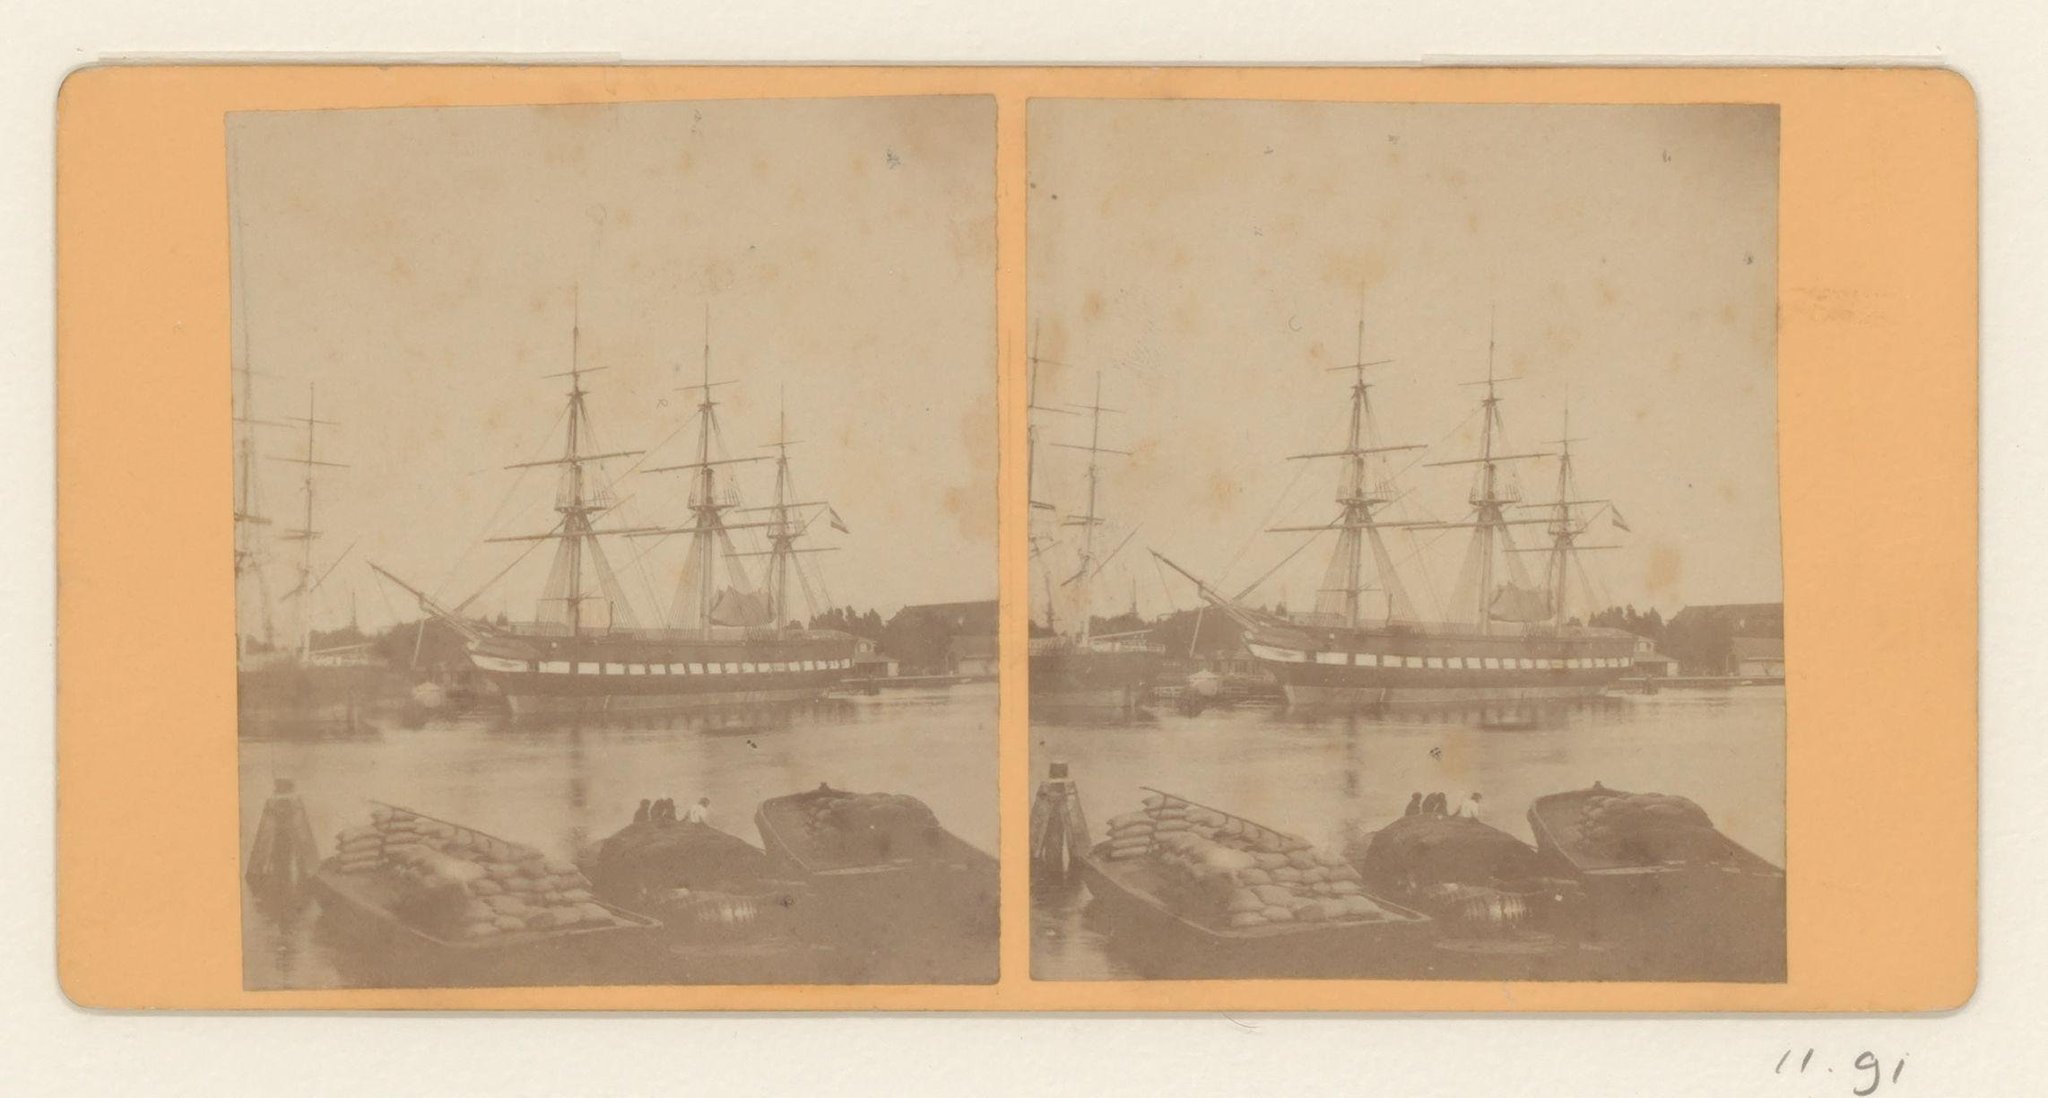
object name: stereograph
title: Gezicht op een schip bij de Prins Hendrikkade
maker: Anonymous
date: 1899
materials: cardboard, paper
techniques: albumen print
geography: amsterdam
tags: city-view in general; 'veduta', river, ships (in general)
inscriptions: inscription: ‘van G. 7.2.99. / 8. Prins Hendrikkade’, collector's mark: ‘11.91’ Lugt 1641b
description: Onderwerpsrubriek binnen de Atlas Amsterdam: Prinsengracht, Korte Prinsengracht, Prins Hendrikkade. Zie ook Portefeuille 1: gezichten van het IJ op de stad.